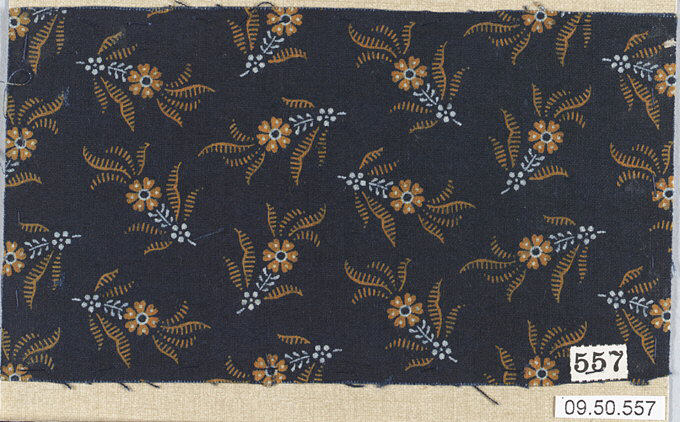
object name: piece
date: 1801-1900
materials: cotton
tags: flowers,leaves